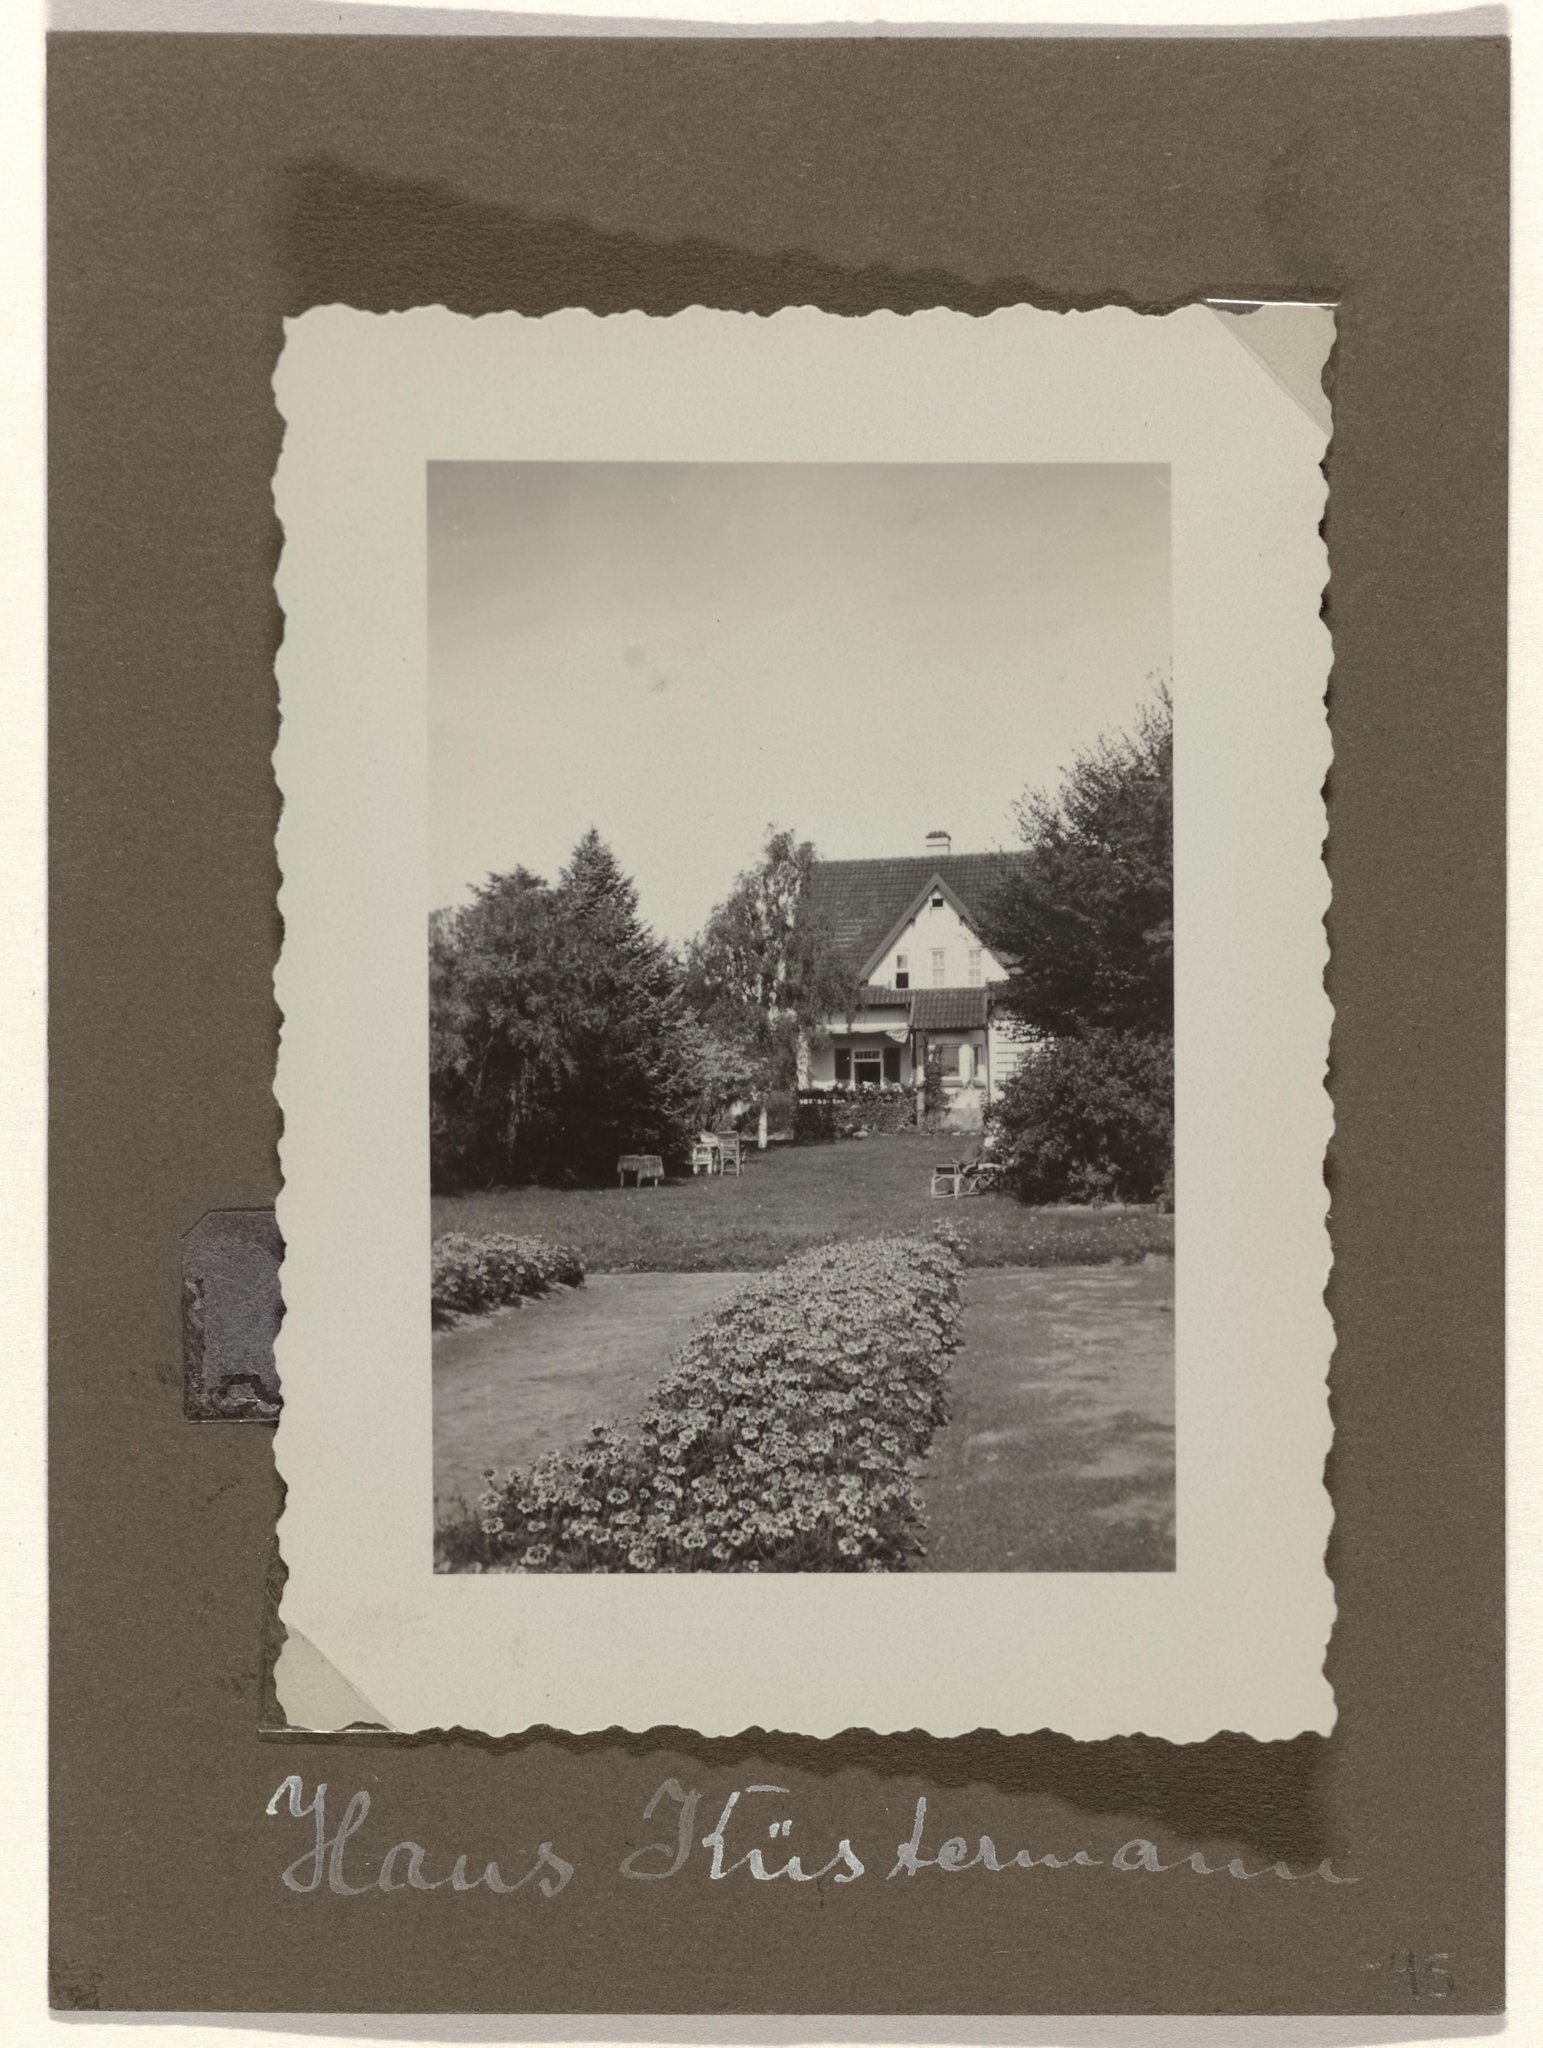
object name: photograph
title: Haus Küstermann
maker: Anonymous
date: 1920-1938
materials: photographic support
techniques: gelatin silver print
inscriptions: inscription: ‘Haus Küstermann’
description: Dit object is onderdeel van de nalatenschap van Isabel Elon-Wachenheimer (1928-2010). Tot haar overlijden behoorde het samen met de andere objecten uit de nalatenschap tot haar privédomein van Isabel Wachenheimer. In die particuliere context zijn deze objecten tezamen en individueel aandenkens - aan de jeugd, ouders en familie van Isabel Wachenheimer vóór en tijdens de Shoah en aan haar leven na de Tweede Wereldoorlog. Isabel Wachenheimer, die van juni 1943 tot mei 1945 gevangen zat in Kamp Westerbork, Theresienstadt, Auschwitz, Lenzing a/d Oberdonau (een buitenkamp van Mauthausen), overleefde de Shoah. Haar ouders – Eugène Wachenheimer en Else Wachenheimer-Moos - werden op 14 oktober 1944 in Auschwitz-Birkenau vermoord.